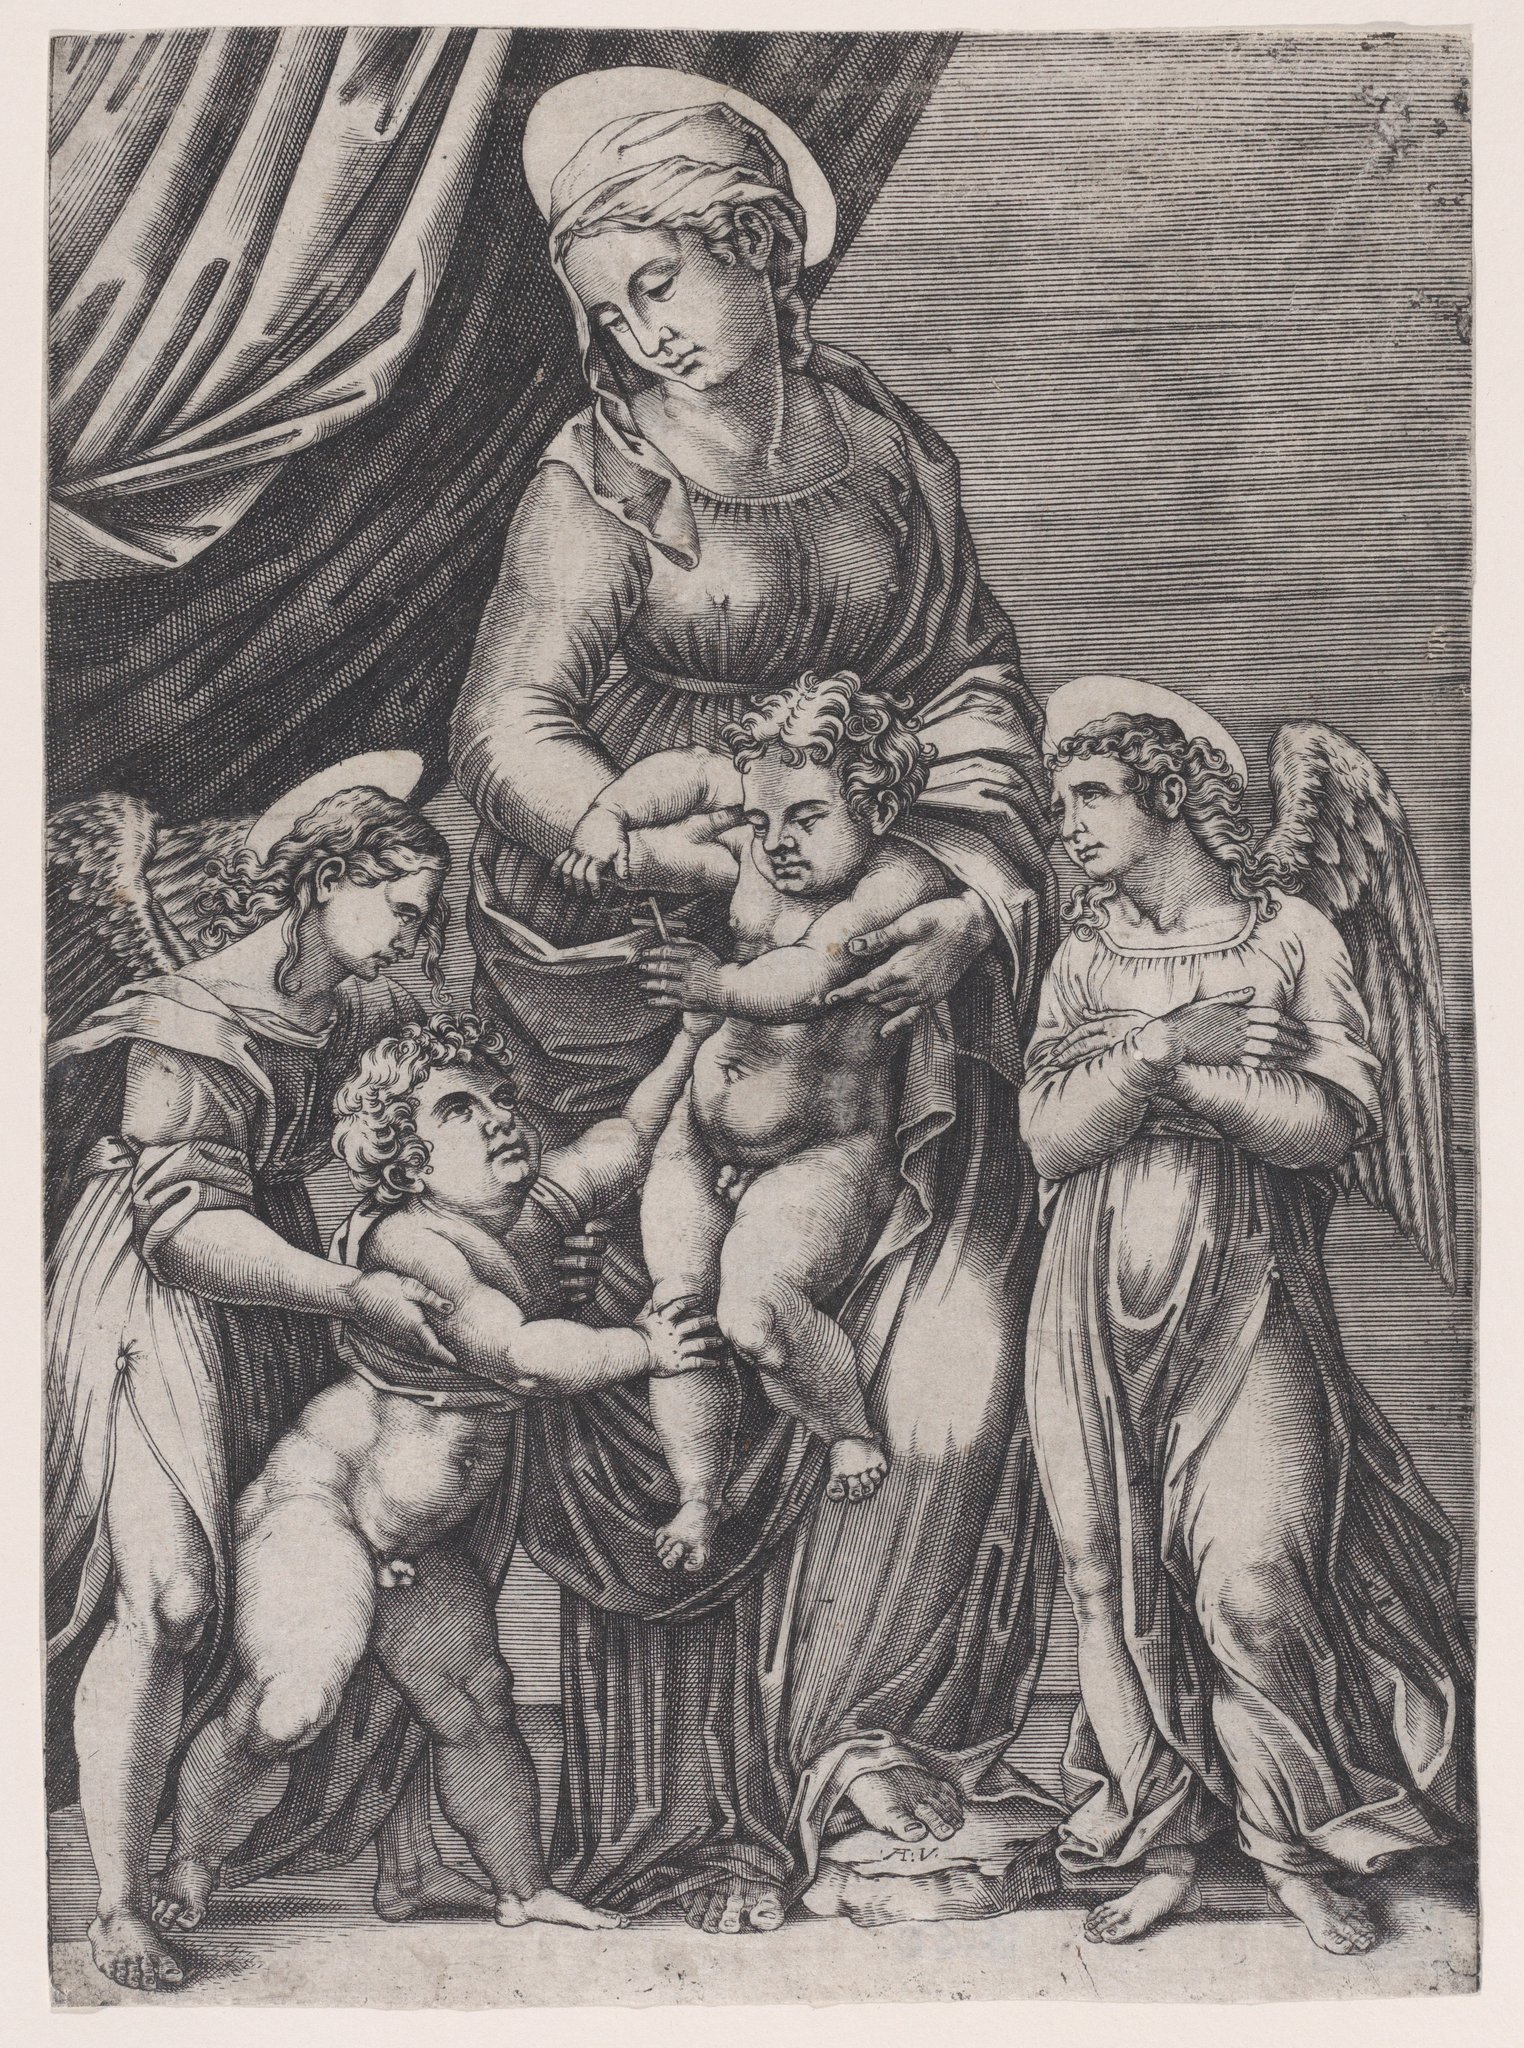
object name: print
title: The Virgin, the Infant Christ, Infant Saint John, and Two Angels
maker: agostino veneziano (agostino dei musi)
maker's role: artist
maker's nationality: italian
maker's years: 1490-1536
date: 1514-1536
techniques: engraving